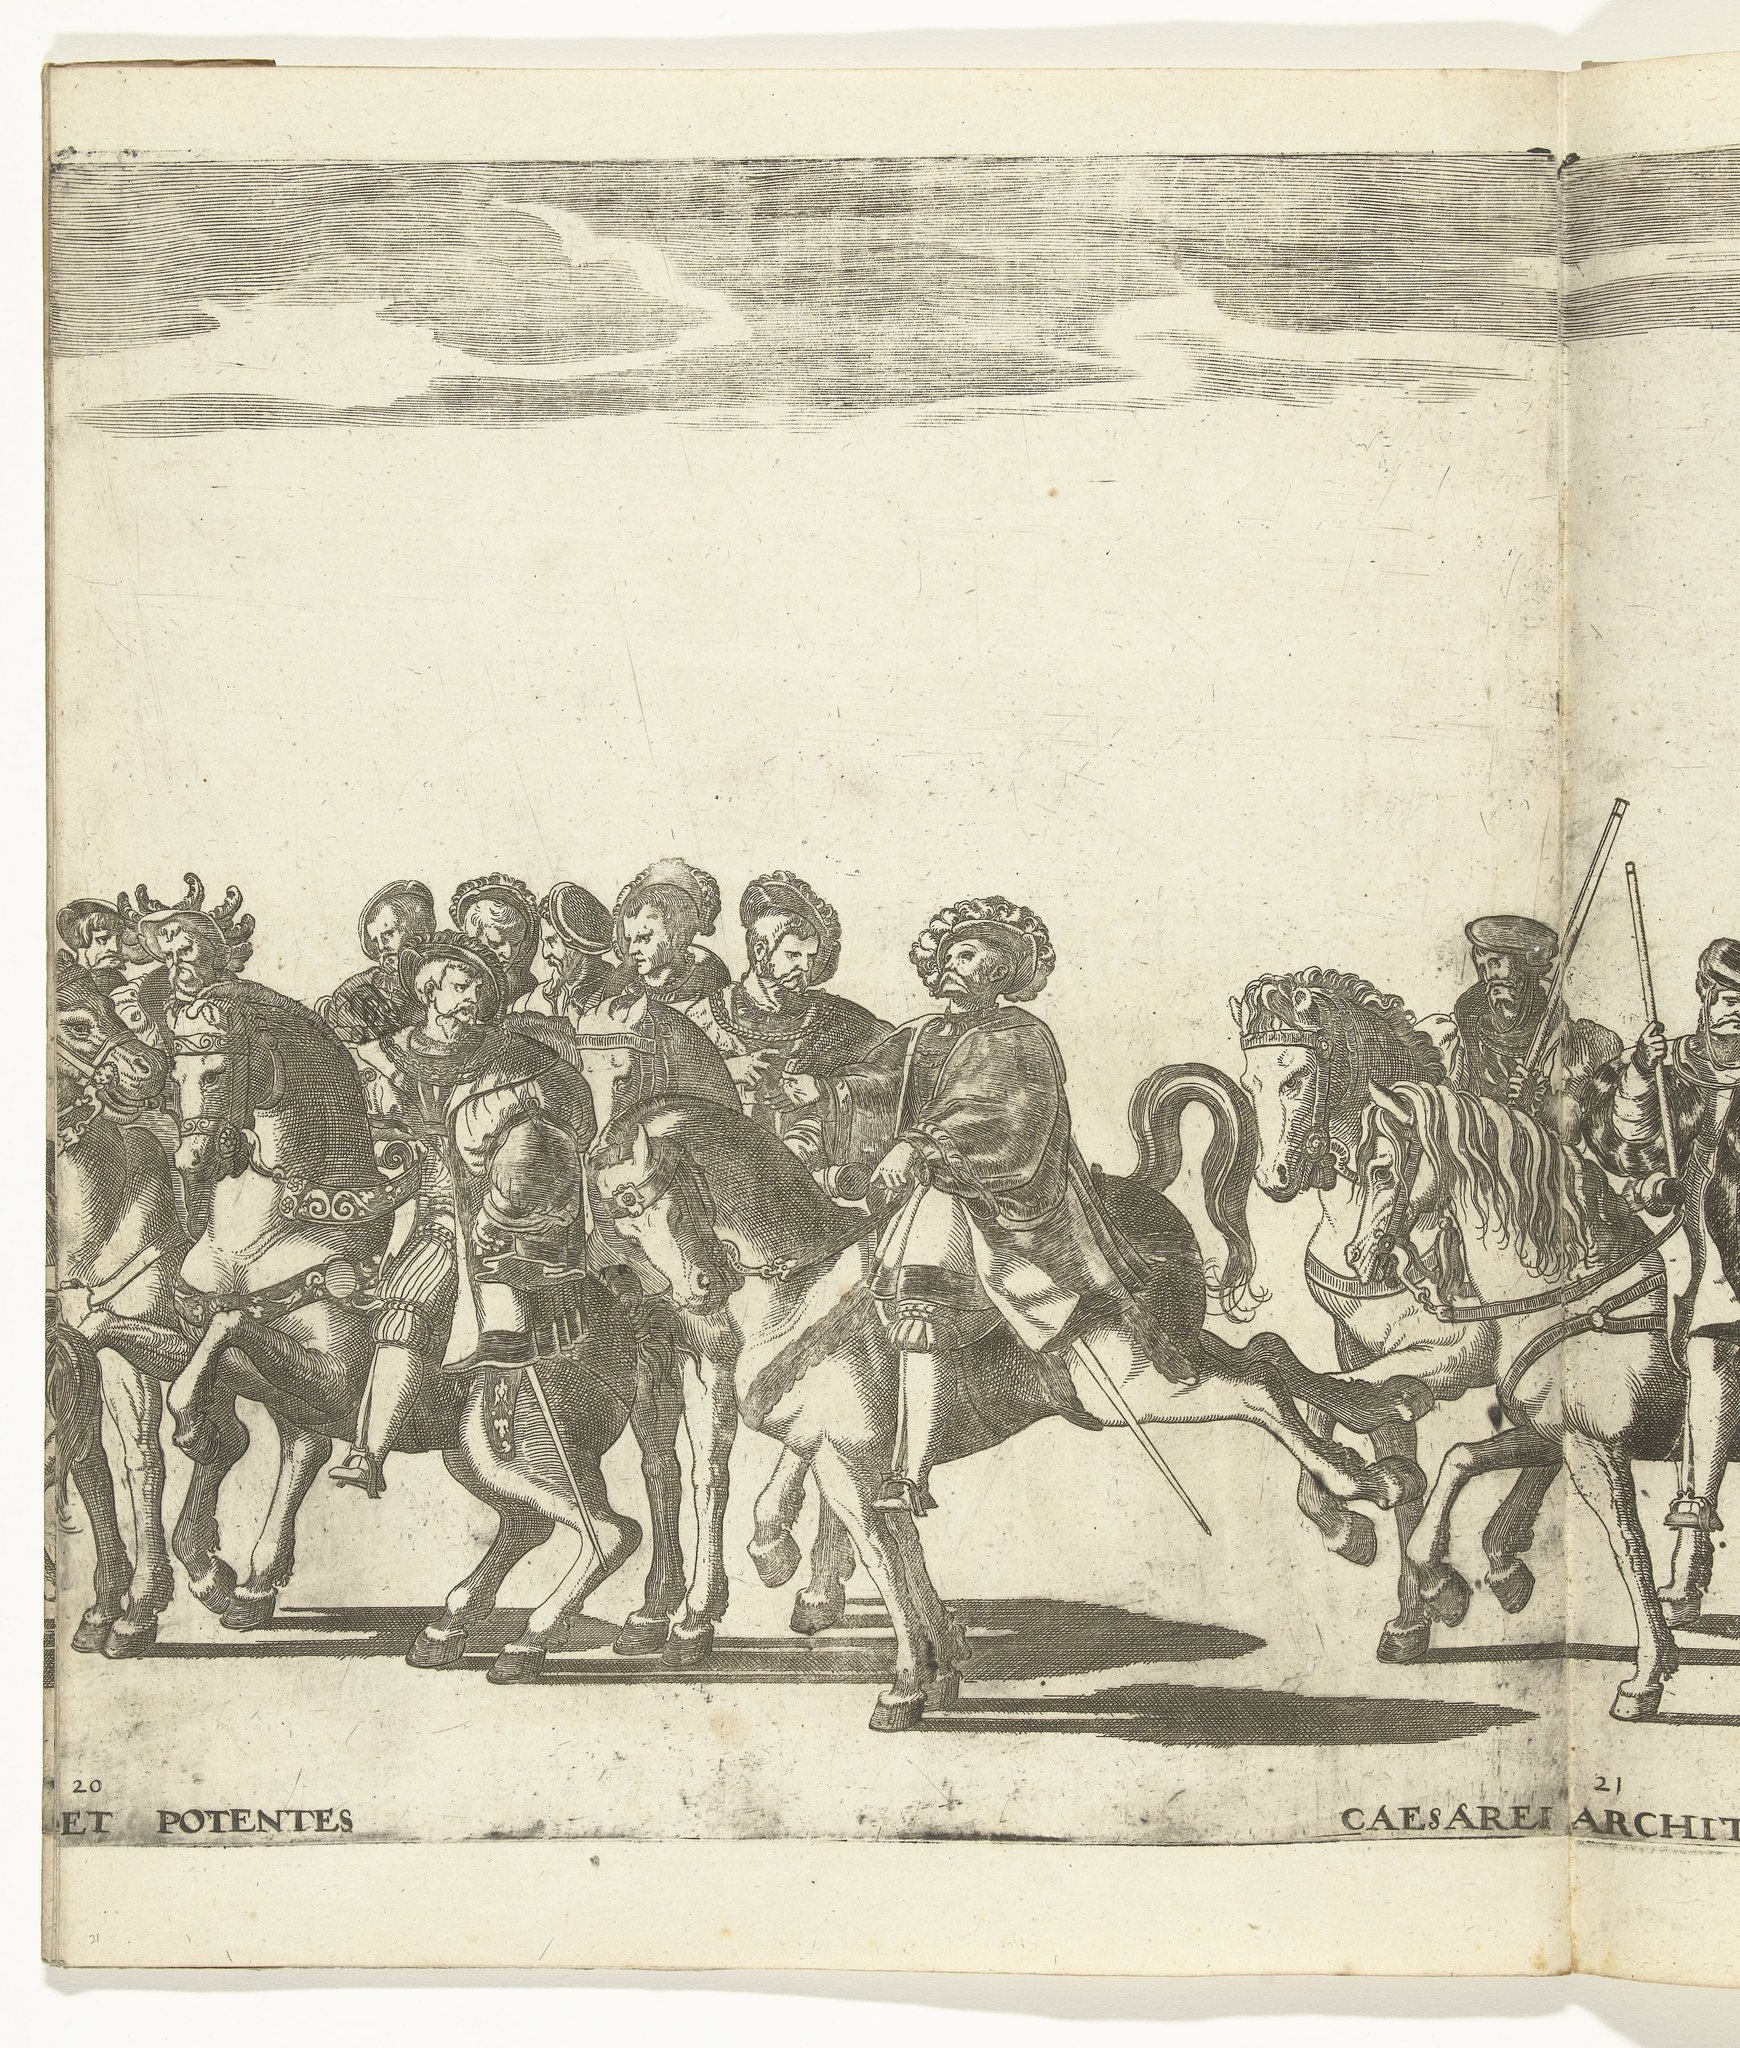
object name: print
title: Optocht van Karel V met de paus te Bologna na zijn kroning tot keizer, 1530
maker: nicolaas hogenberg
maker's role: draughtsman, painter, print maker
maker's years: 1500-1539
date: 1530-1536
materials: paper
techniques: engraving, etching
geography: mechelen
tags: charles v (holy roman emperor and king of spain), festivities (+ parade, pageant, cavalcade ~ festive activities)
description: In plaats van de geneologische afstamming van Karel V in het huis van Oostenrijk is in deze uitgave bovenin de platen een nieuw lucht gegraveerd. De platen zijn genummerd 1-38. Deze uitgave is later dan die van Hondius. De platen zijn aanelkaar geplakt en vormen zo één lang (opgevouwen) fries. Het opgevouwen fries ligt los in een map.